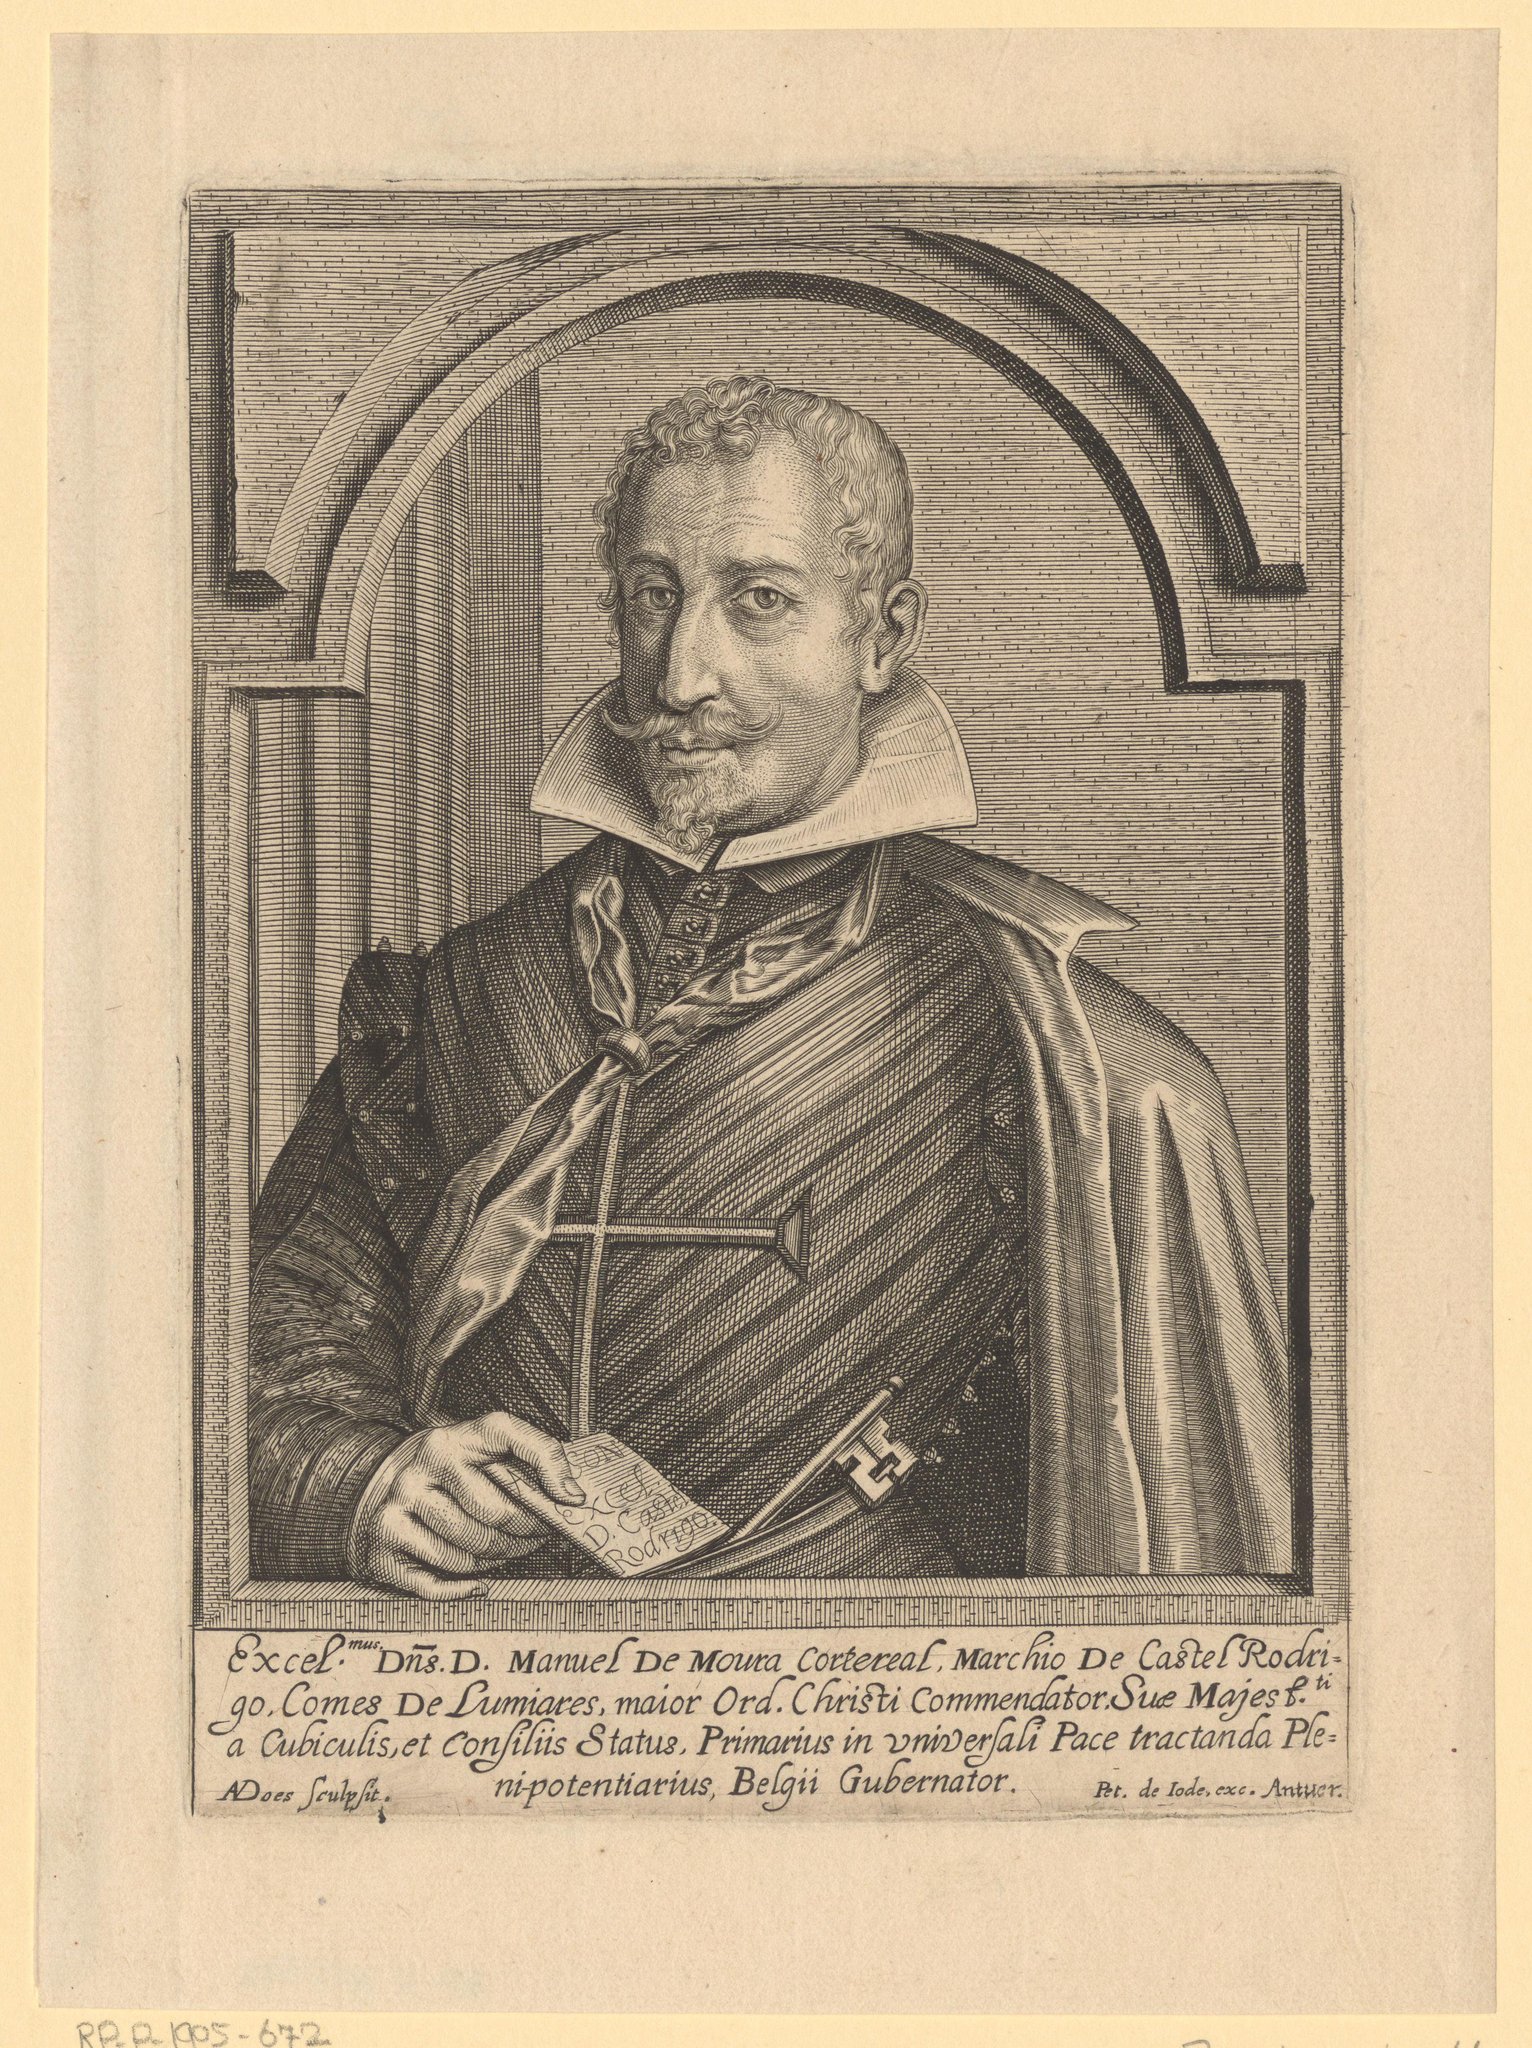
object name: print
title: Portret van Manuel de Castel Rodrigo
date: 1619-1634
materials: paper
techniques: engraving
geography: antwerp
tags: historical persons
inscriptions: collector's mark: Lugt 2228